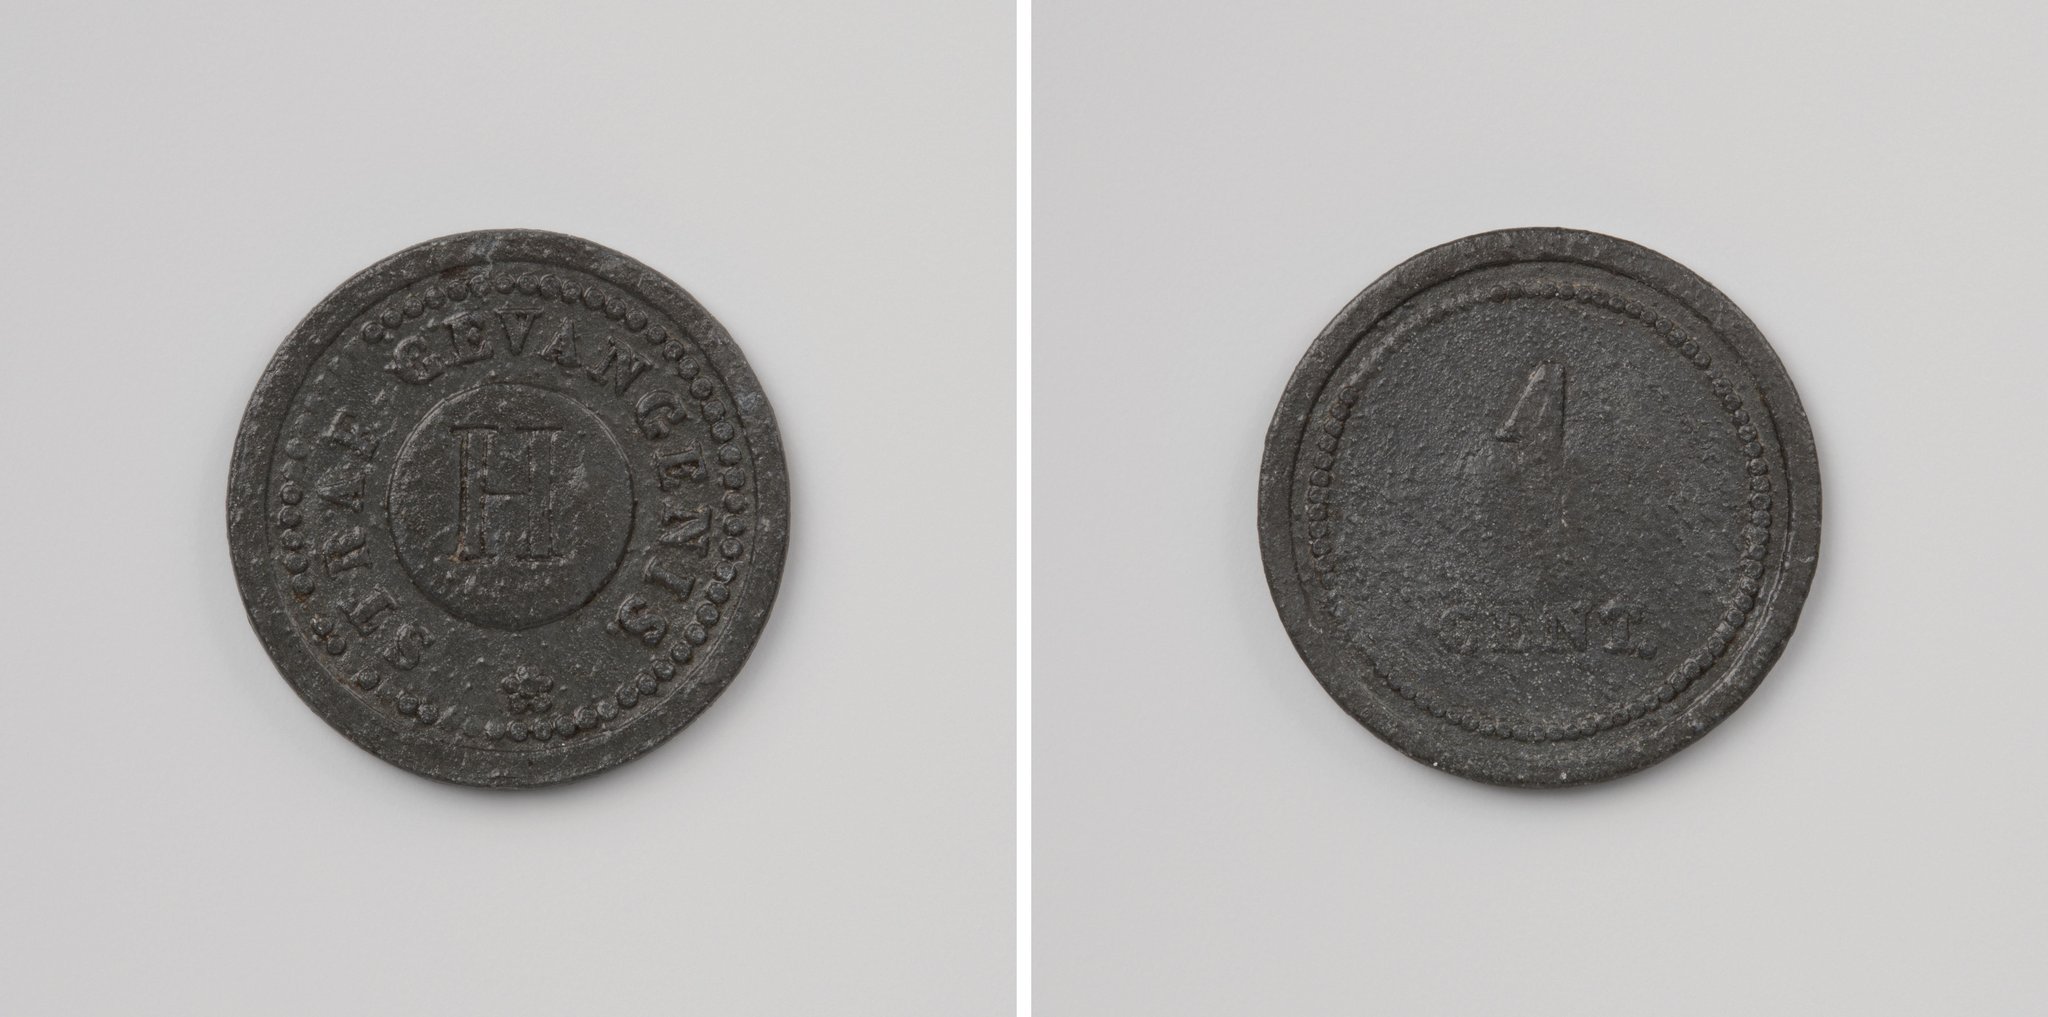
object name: monetary token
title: Strafgevangenis te Hoorn, huismunt ter waarde van een cent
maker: Anonymous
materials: zinc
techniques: striking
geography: utrecht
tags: hoorn (north holland)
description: Zinken betaalpenning. Voorzijde: letter H binnen omschrift. Keerzijde: waardeaanduiding